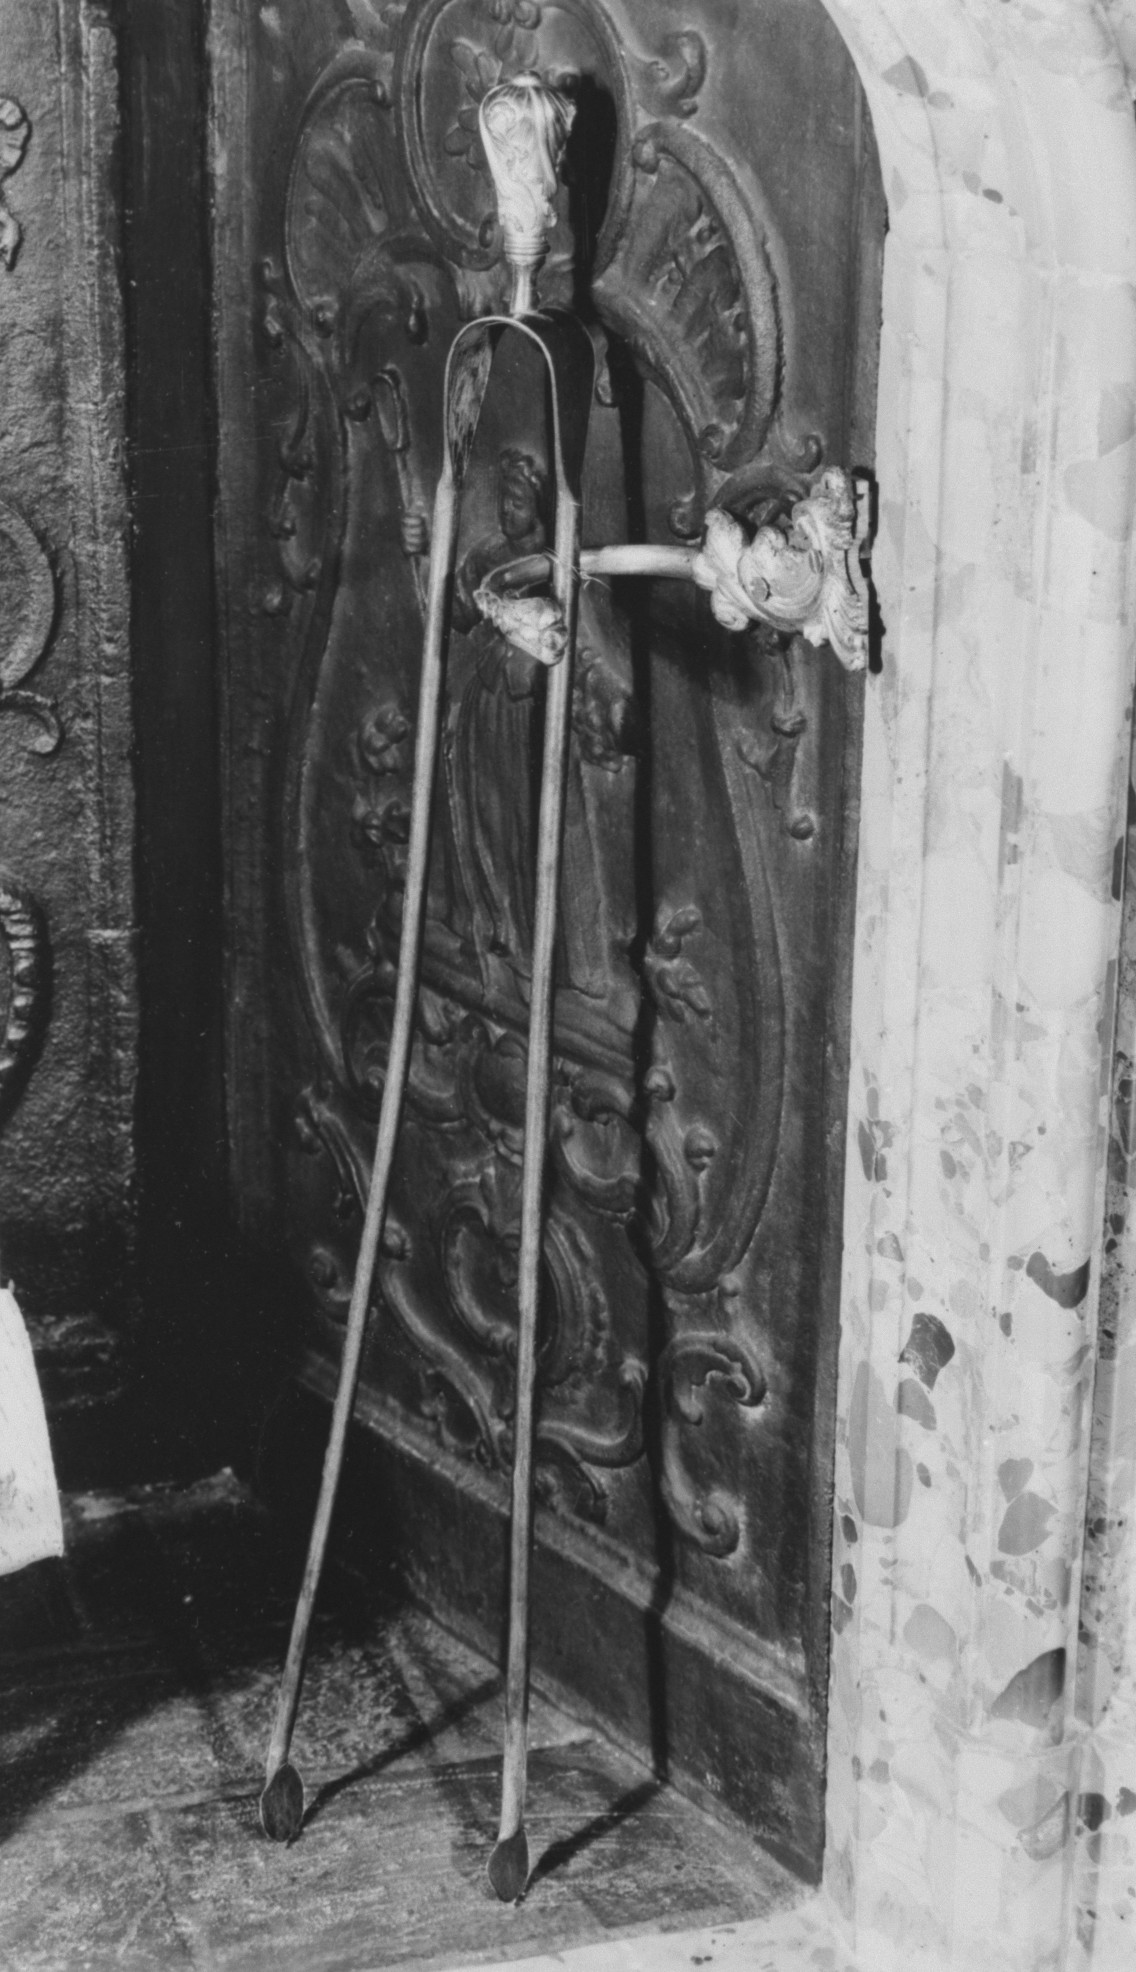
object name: tongs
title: Tongs (part of a set)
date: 1730-1760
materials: gilt bronze, steel